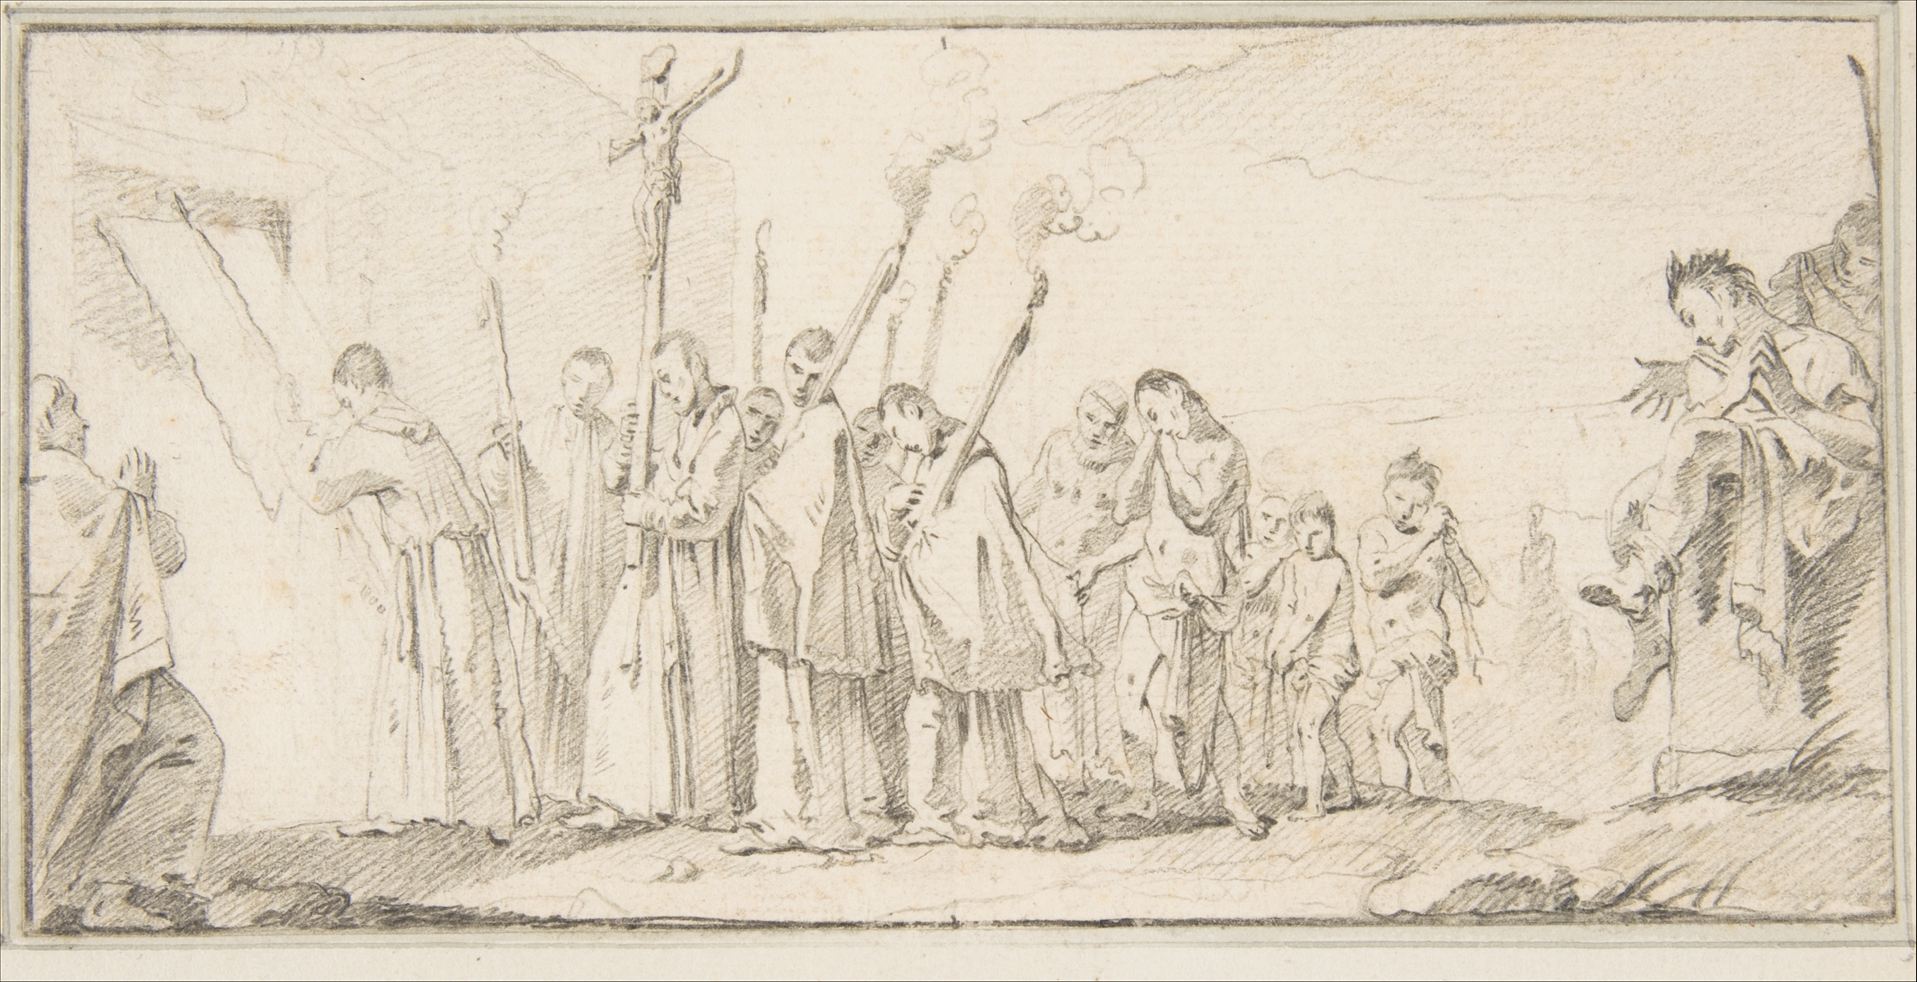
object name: drawing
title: Illustration for a Book: Procession of Monks and Flagellants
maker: giovanni battista tiepolo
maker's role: artist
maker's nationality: italian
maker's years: 1696-1770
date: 1696-1770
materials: chalk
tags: cross,monks